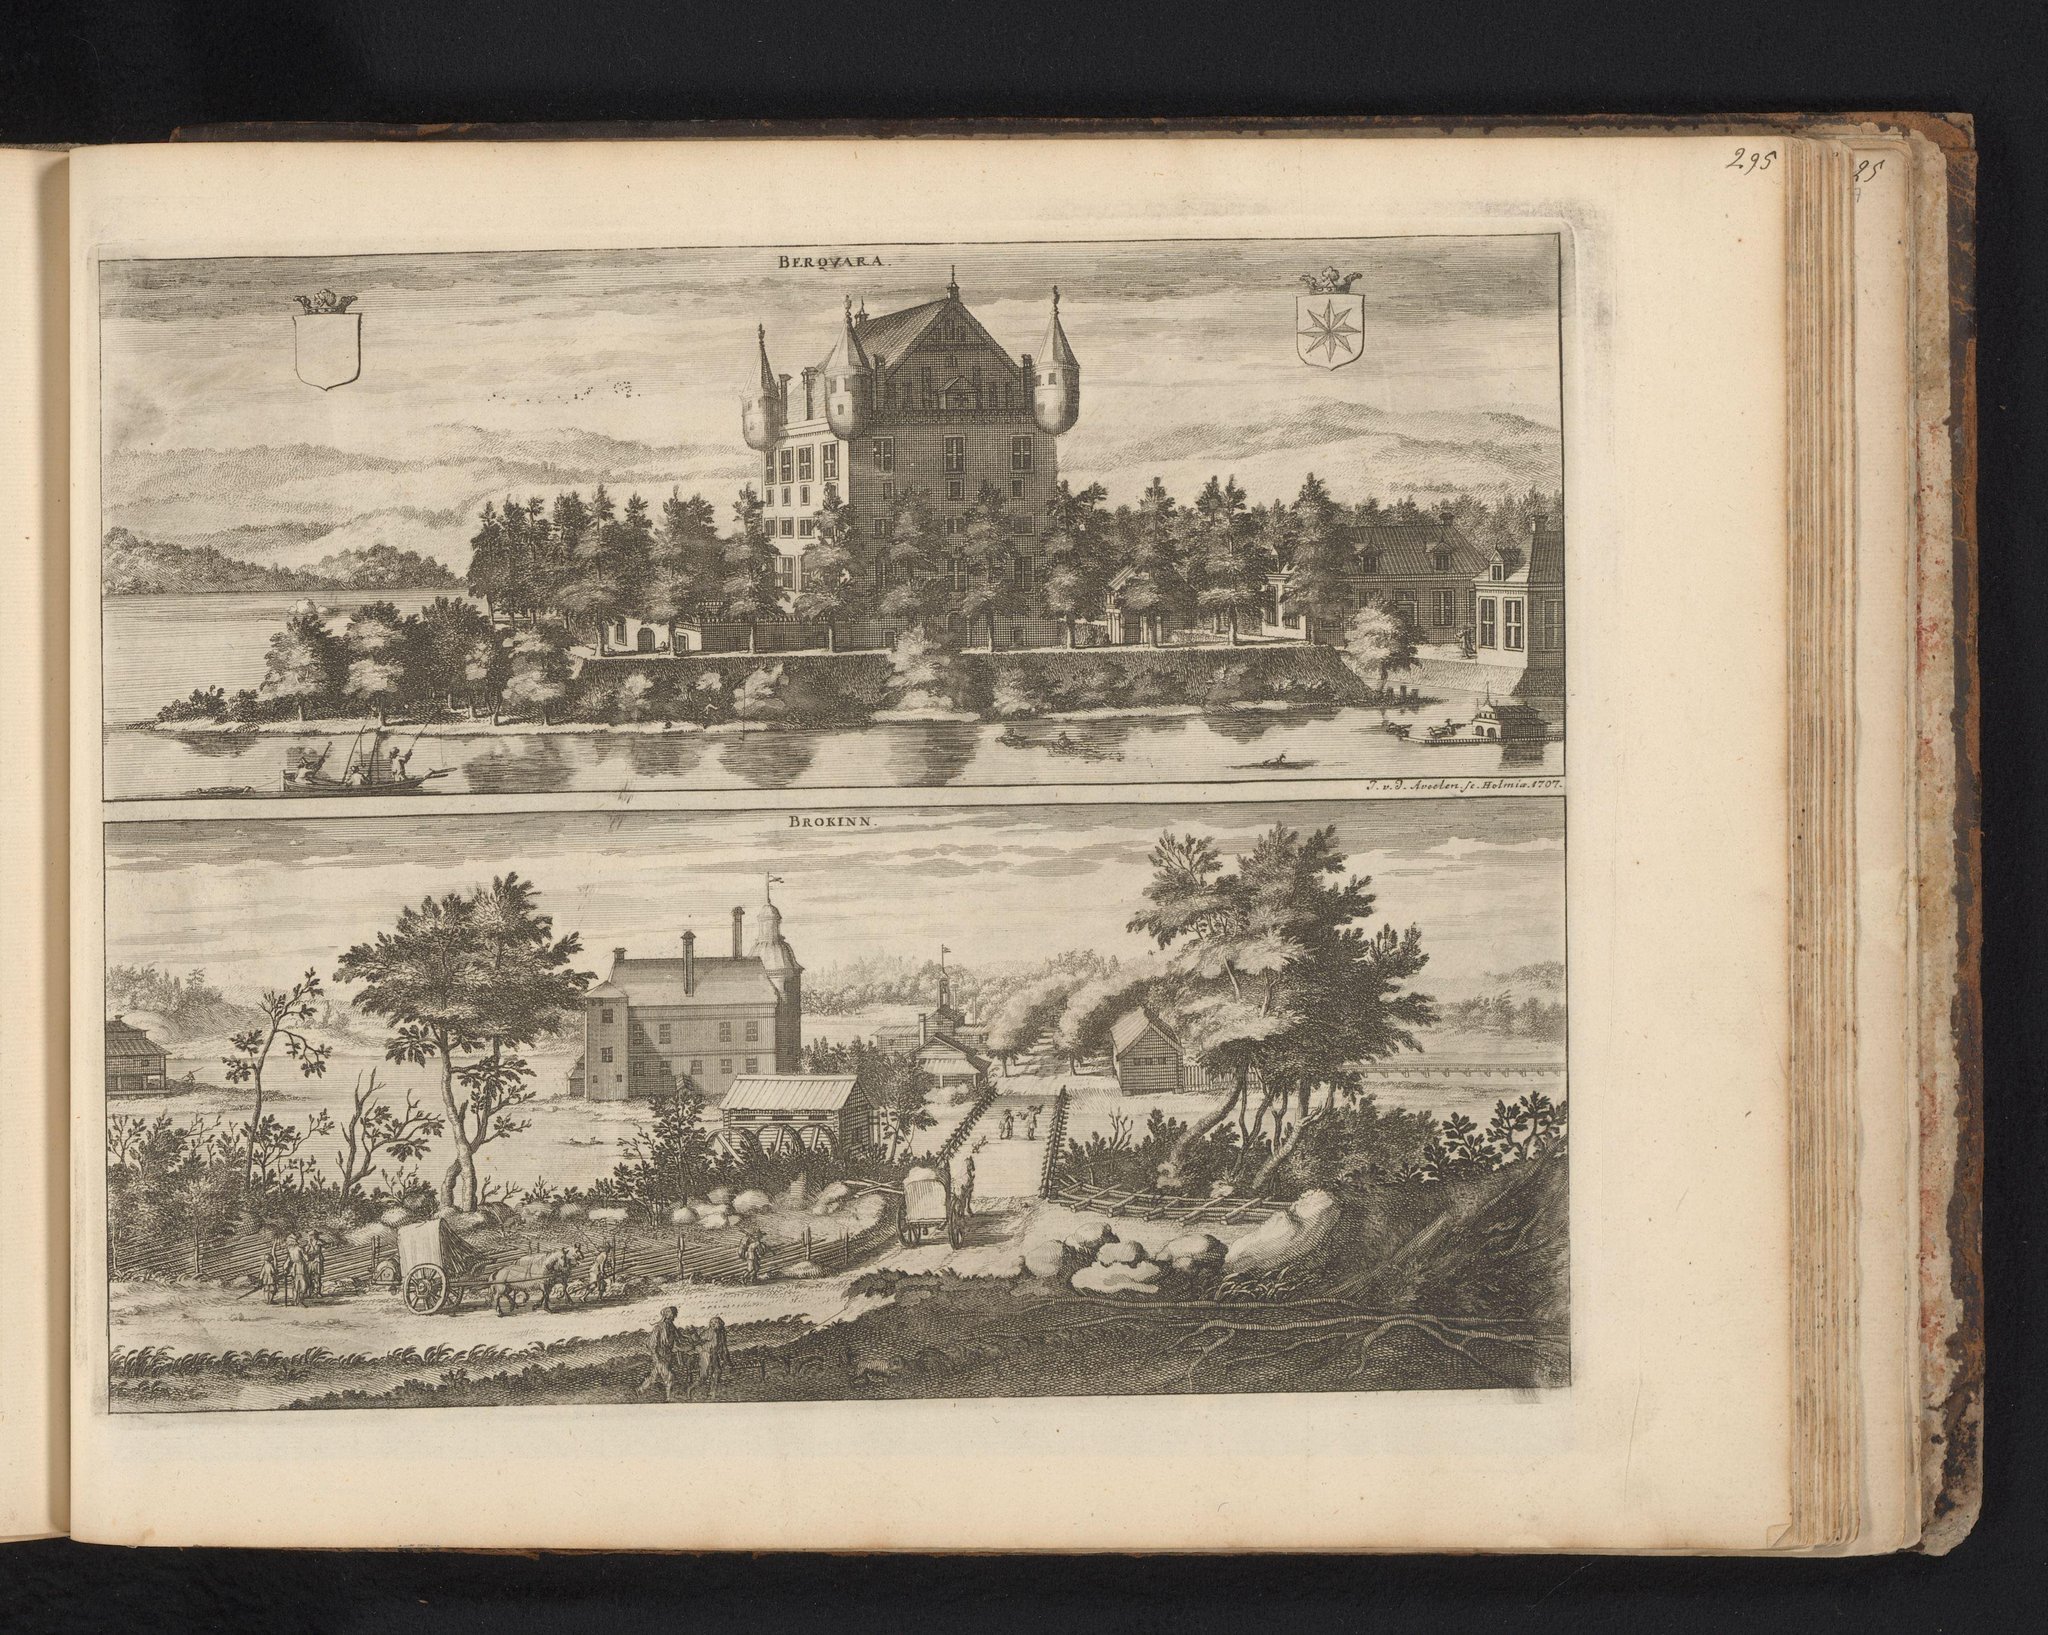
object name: album leaf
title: Bergqvara / Brokinn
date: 1707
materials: paper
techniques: etching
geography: stockholm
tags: housing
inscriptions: date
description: Kungliga Biblioteket, 'Suecia': http://www.kb.se/samlingarna/Kartor-bilder/Suecia-antiqua/ (geraadpleegd november 2016).